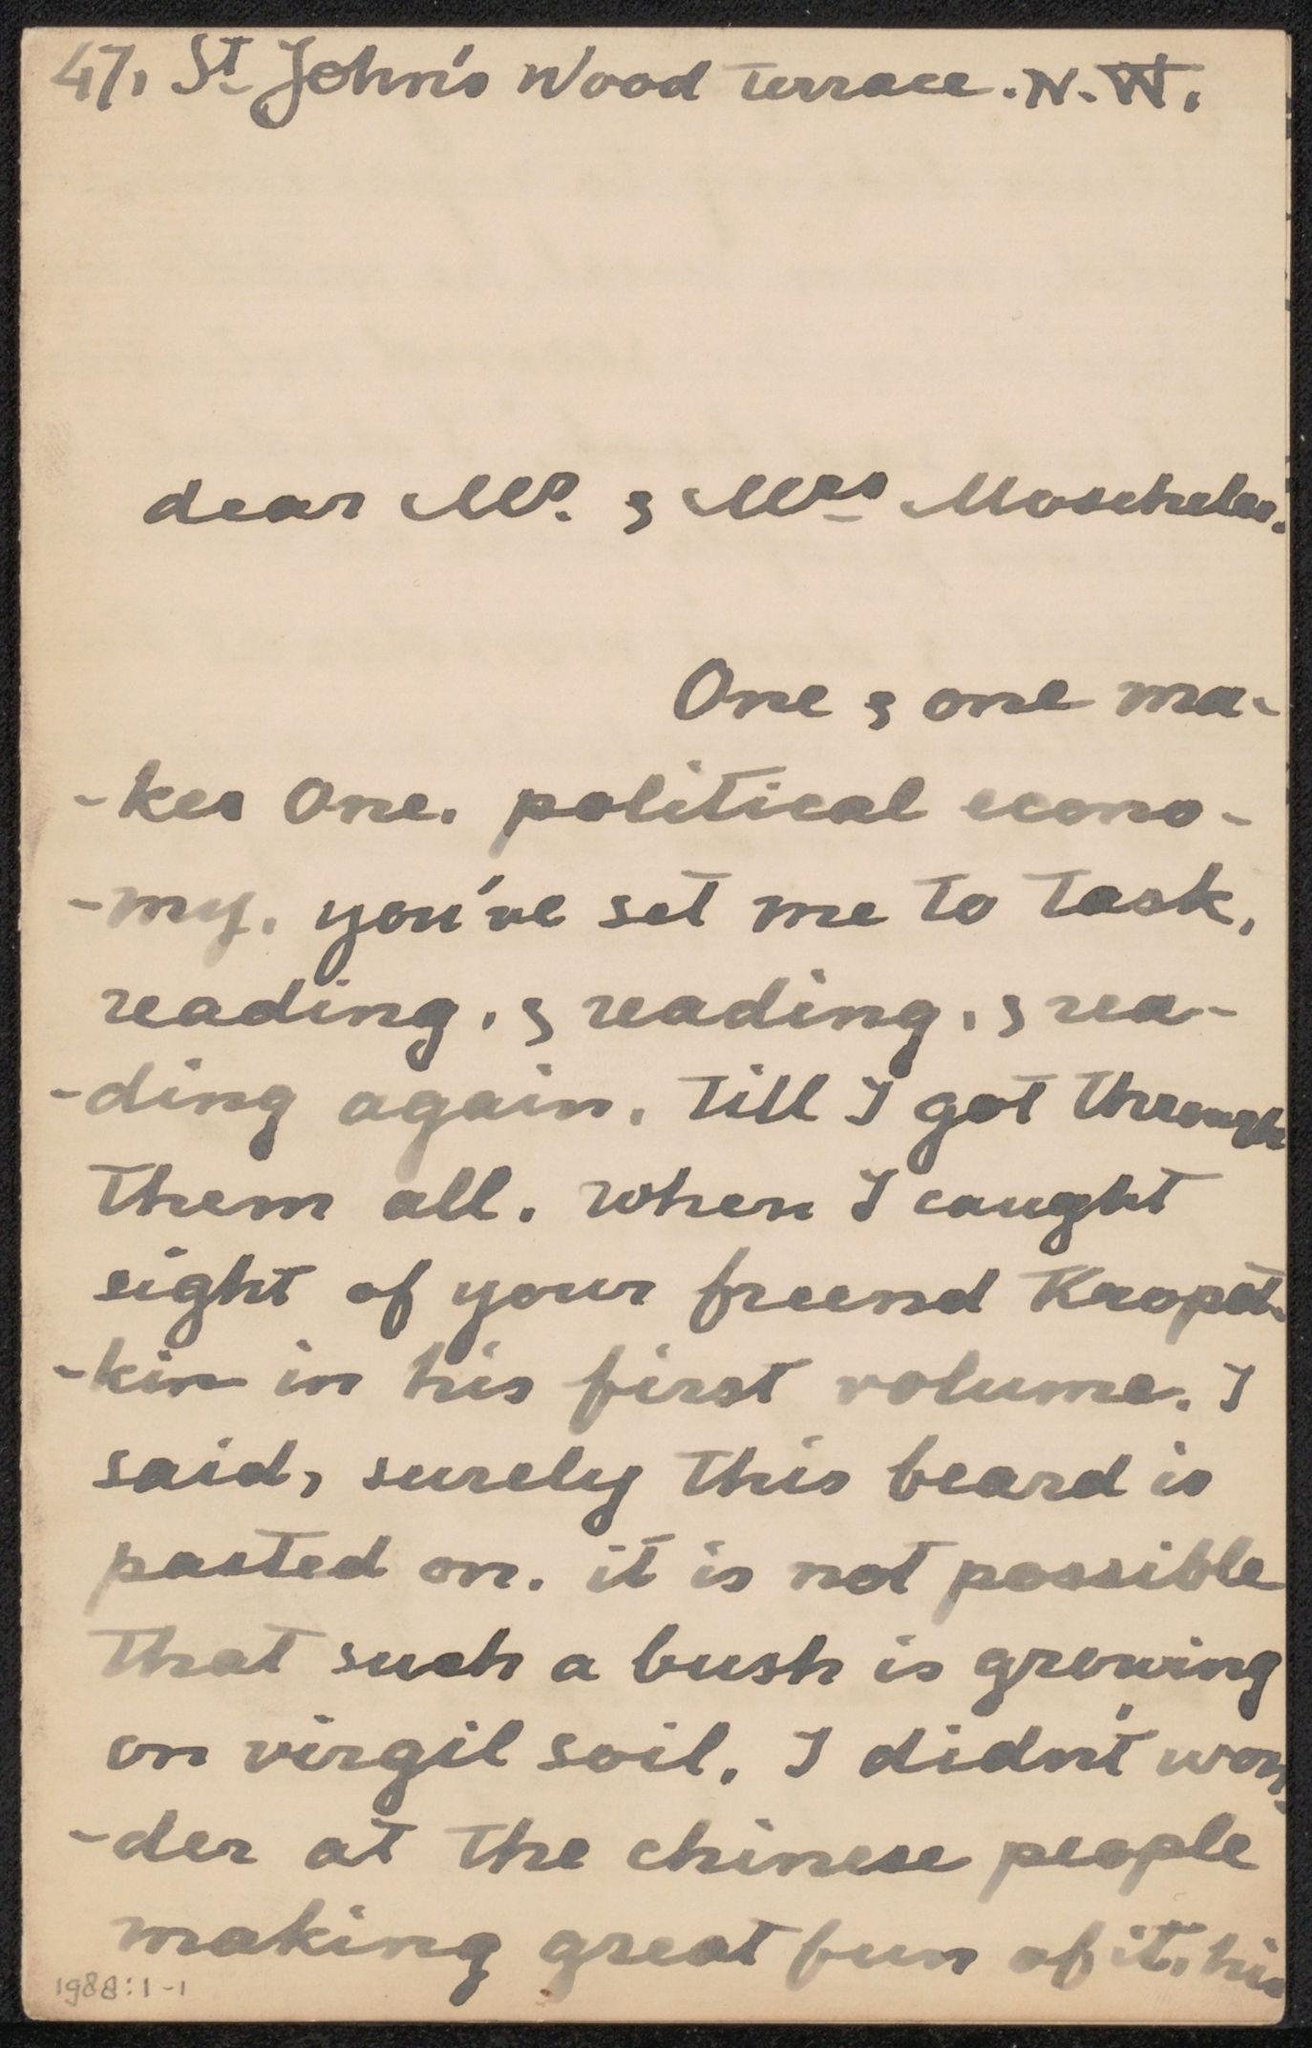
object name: letter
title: Brief aan Felix Stone Moscheles en mevrouw Moscheles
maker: matthijs maris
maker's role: draughtsman, painter, print maker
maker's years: 1839-1917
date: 1888-1906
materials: ink, paper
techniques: pen, writing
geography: london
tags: jean françois millet, john ruskin, literature ~ arts, the graphic arts, painting (including book-illumination, miniature-painting)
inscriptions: watermark